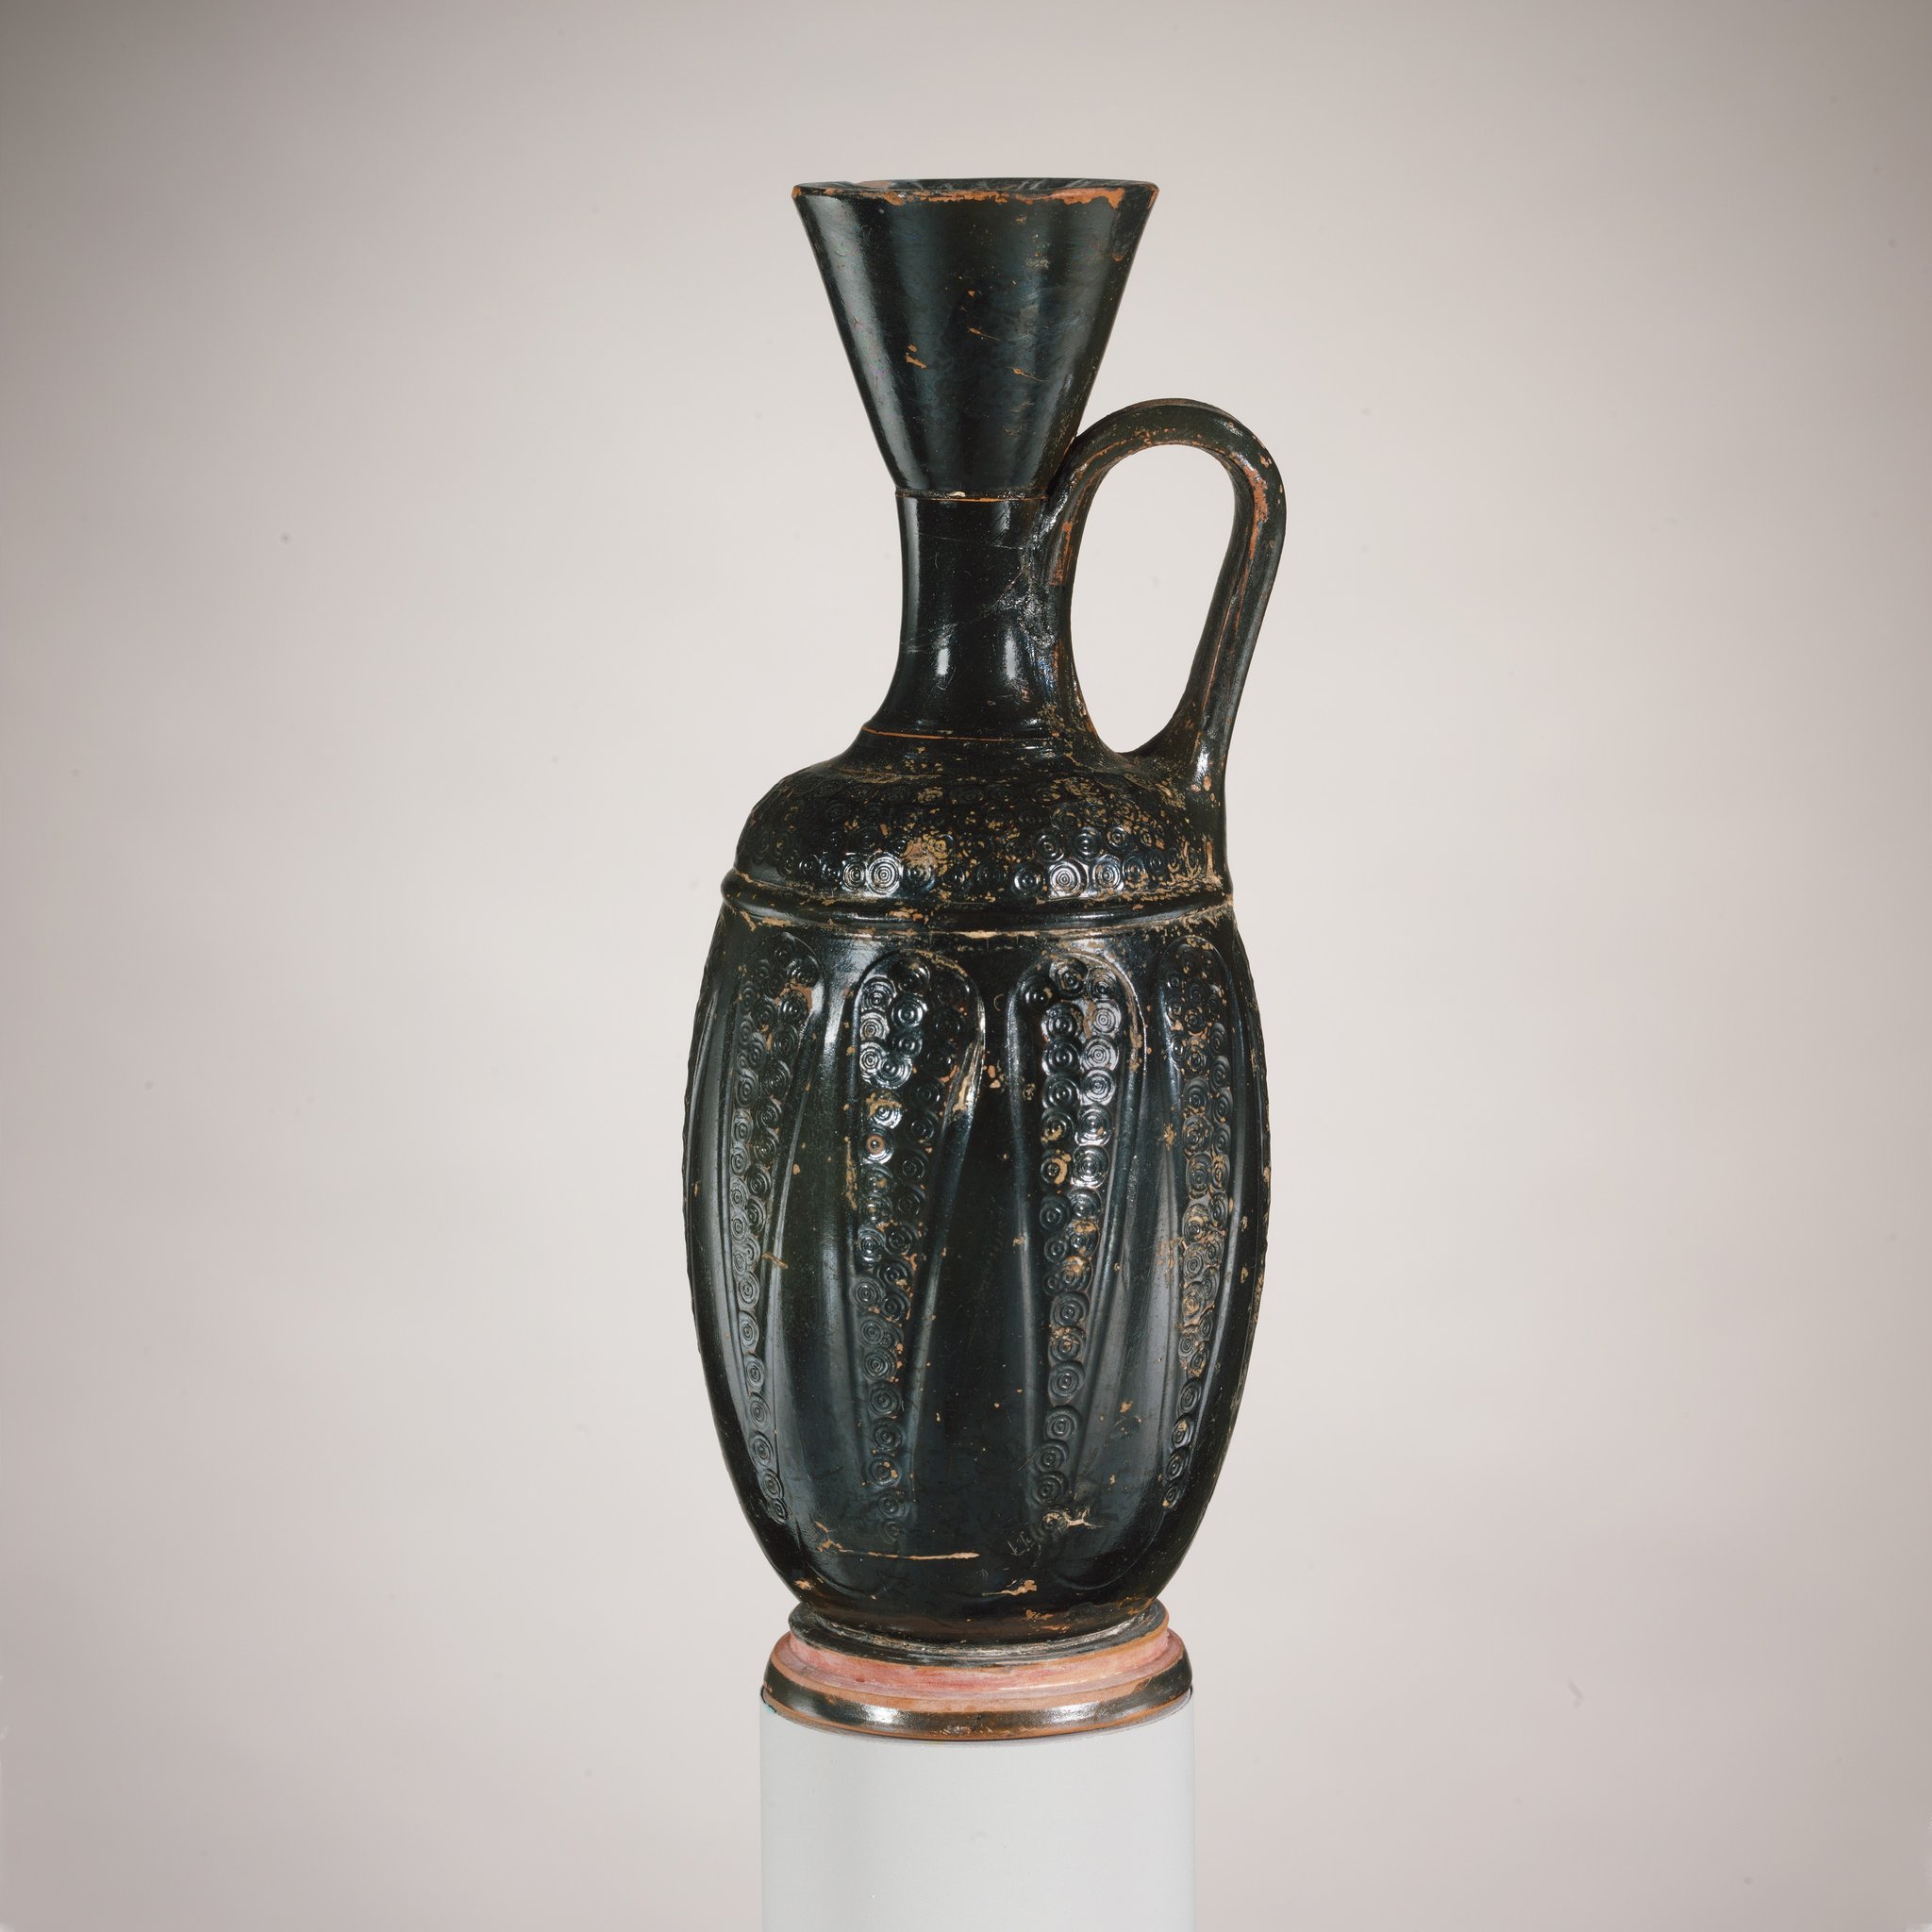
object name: lekythos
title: Terracotta lekythos (oil flask)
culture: greek, boeotian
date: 400-301 BCE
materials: terracotta